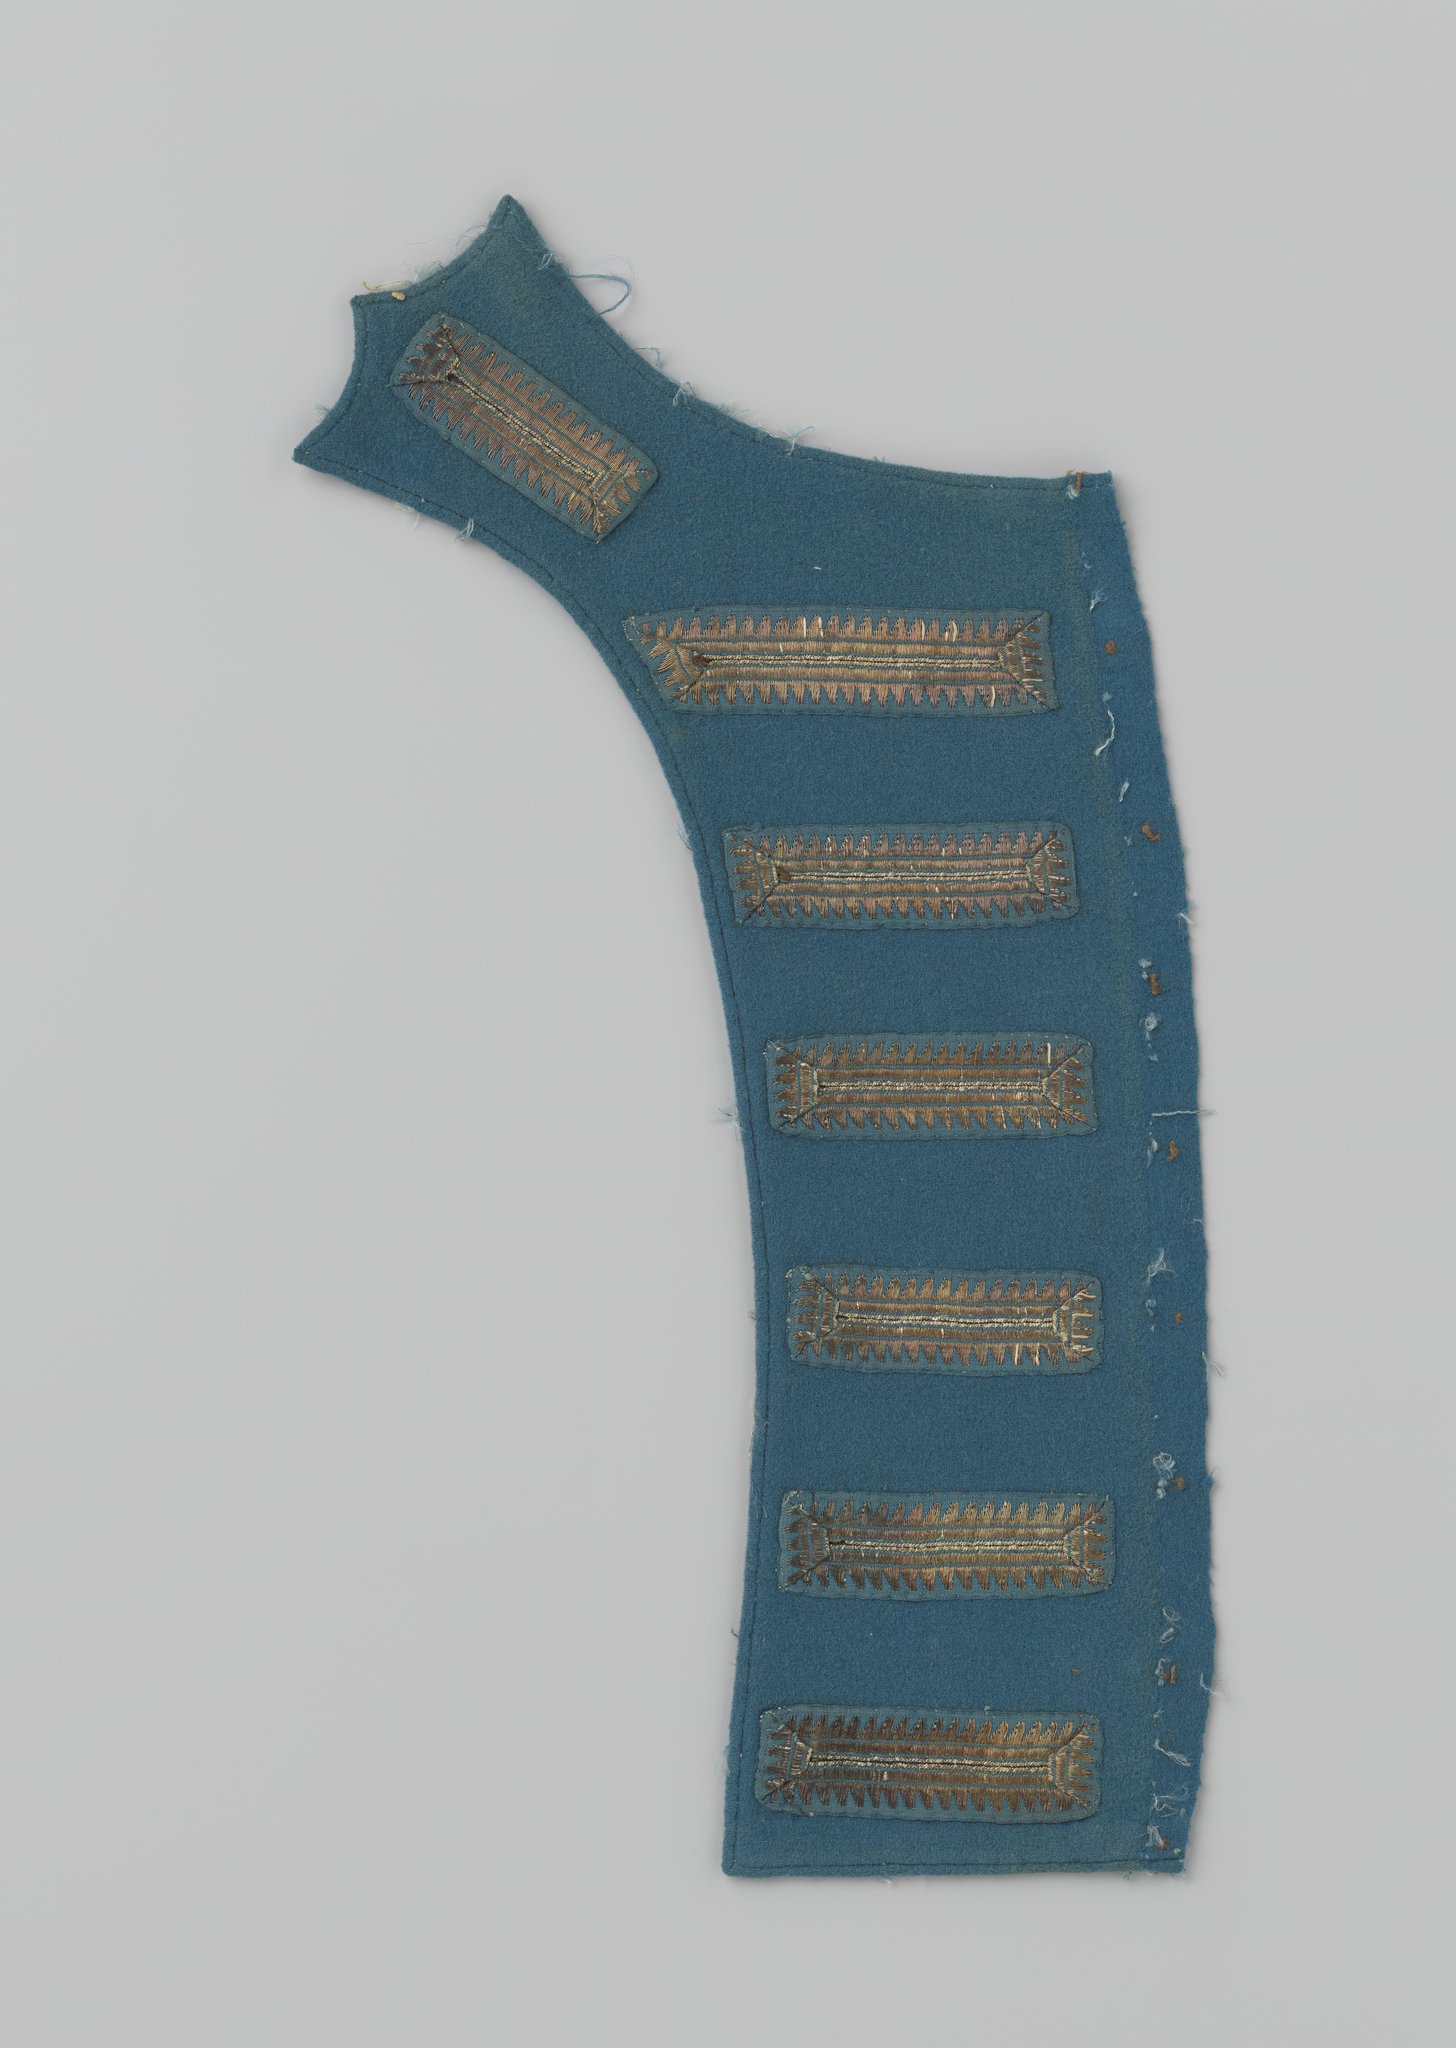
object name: uniform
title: Revers van blauw laken met zeven applicaties van zilverborduursel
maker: Anonymous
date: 1800-1825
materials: textile, thread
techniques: appliqué, embroidered, sewing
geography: netherlands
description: Uniformfragmenten bestaande uit: twee kragen, manchetomslagen, paar revers met één en zeven paar lissen, voering en rug- en voorpanden; voor livrei of schutterij (?). Deze uniformfragmenten waren op het moment van invoer nog niet beschikbaar en daar de aantallen e.d. onduidelijk zijn, is bij deze invoer alleen volstaan met de vermelding van de diverse onderdelen. De invoer per onderdeel moet dus nog volgen.